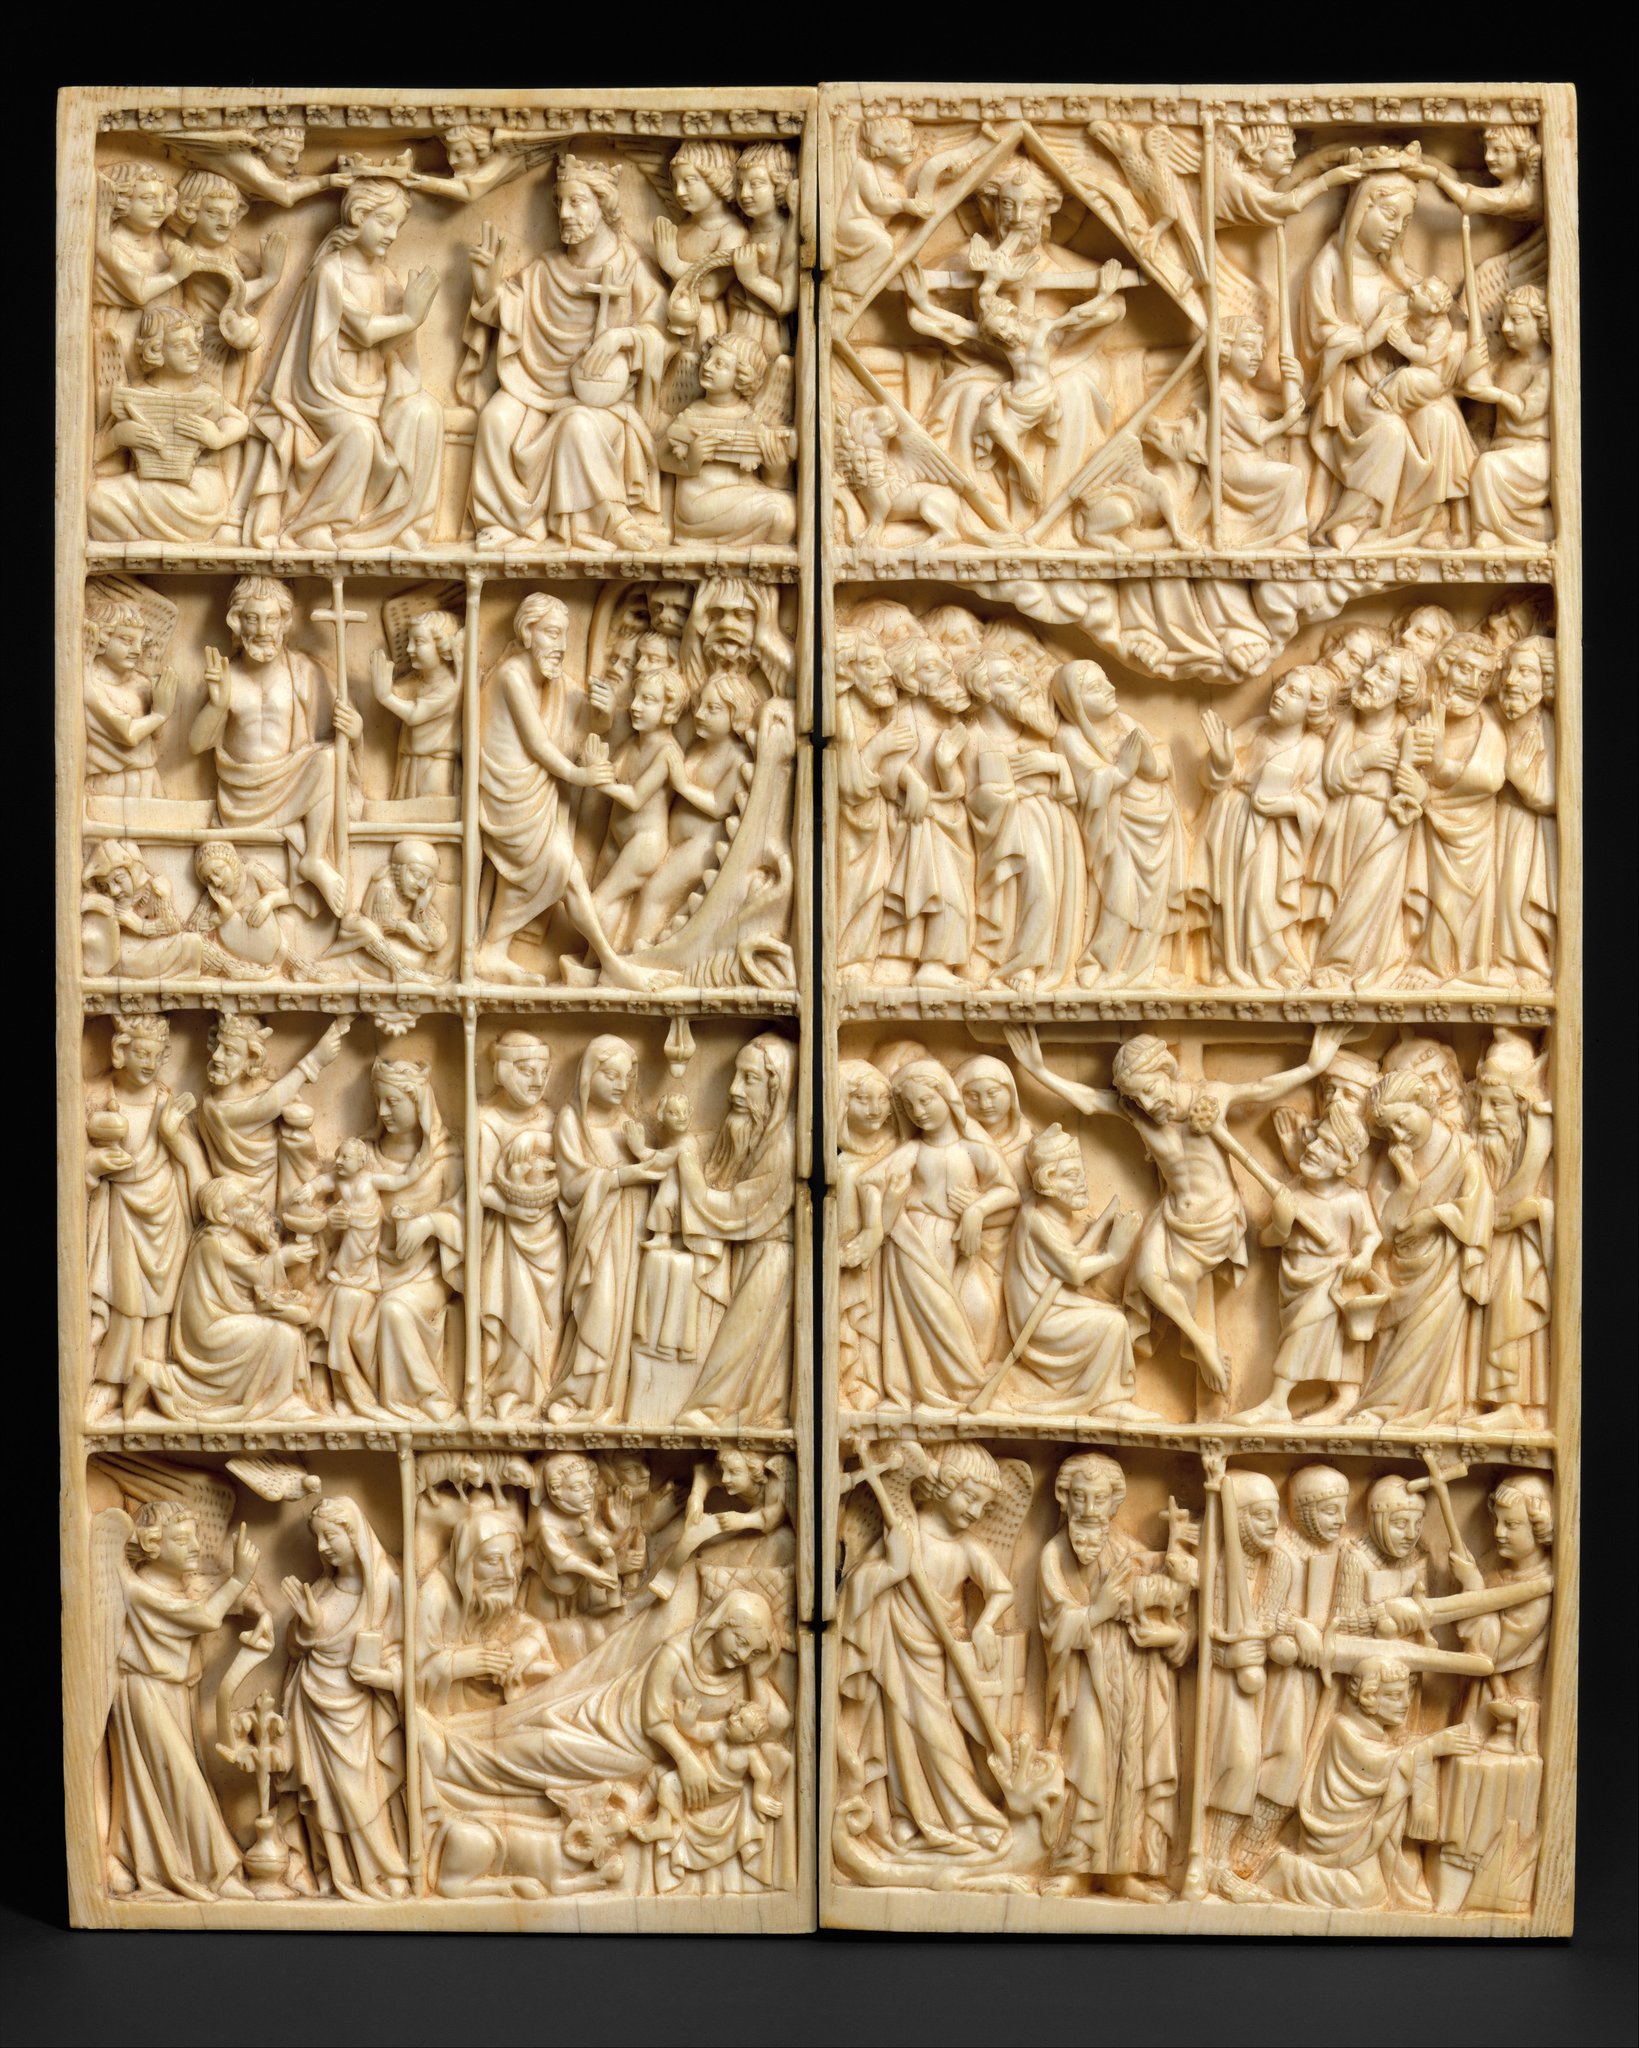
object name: diptych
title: Diptych with Scenes of the Life of Christ and the Virgin, Saint Michael, John the Baptist, Thomas Becket, and the Trinity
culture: german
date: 1350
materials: ivory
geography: germany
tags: christ,saint john the baptist,saint michael,virgin mary,annunciation,crucifixion,resurrection